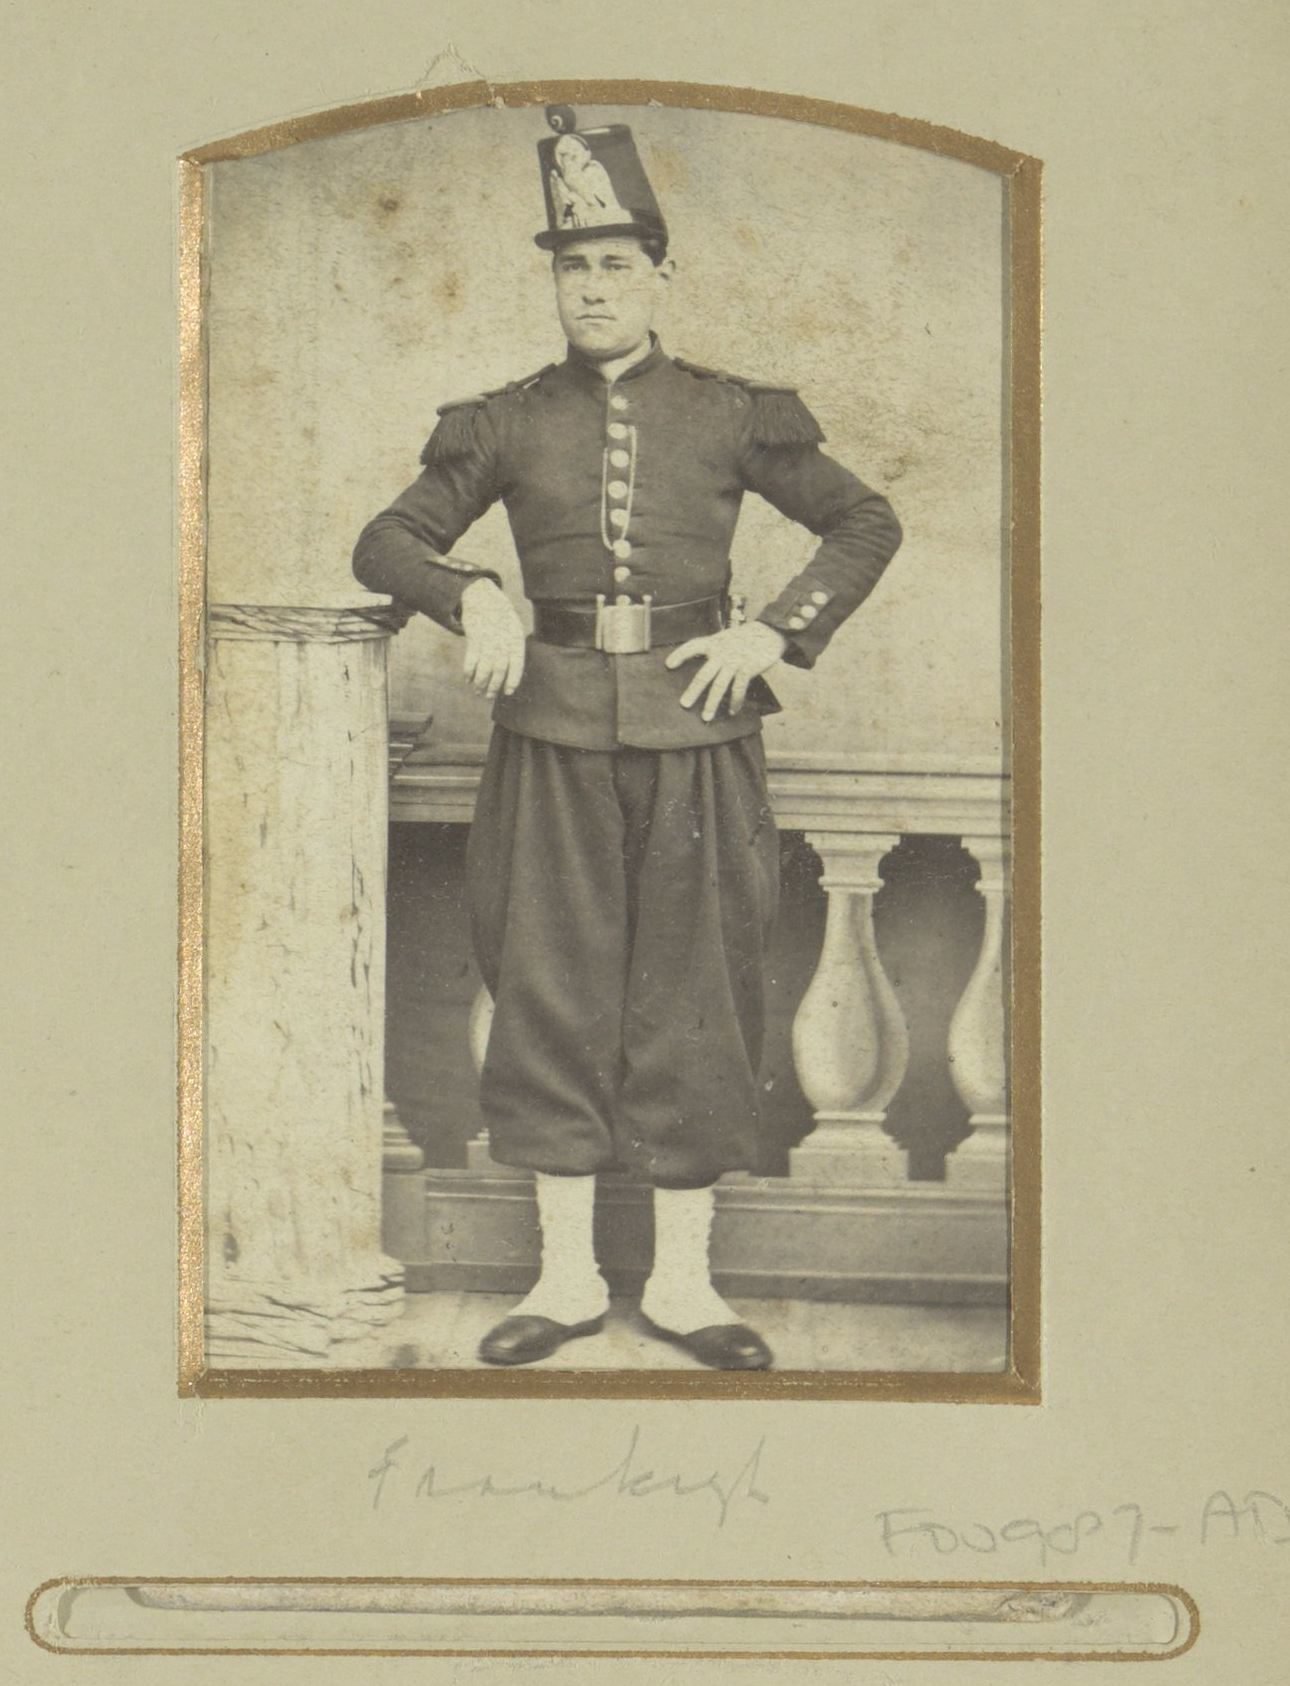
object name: album leaf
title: Portret van een (vermoedelijk) Franse militair, staand in een driekwartbroek met pet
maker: peronet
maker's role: fotograaf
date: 1870-1900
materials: cardboard, paper, photographic support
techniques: albumen print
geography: chambéry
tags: trousers, breeches, head-gear: cap, warfare; military affairs, (military) uniforms, division of armed forces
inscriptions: address: ‘Chambéry’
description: Onderdeel van Album met cartes-de-visite en kabinetfoto's van militairen in uniform.